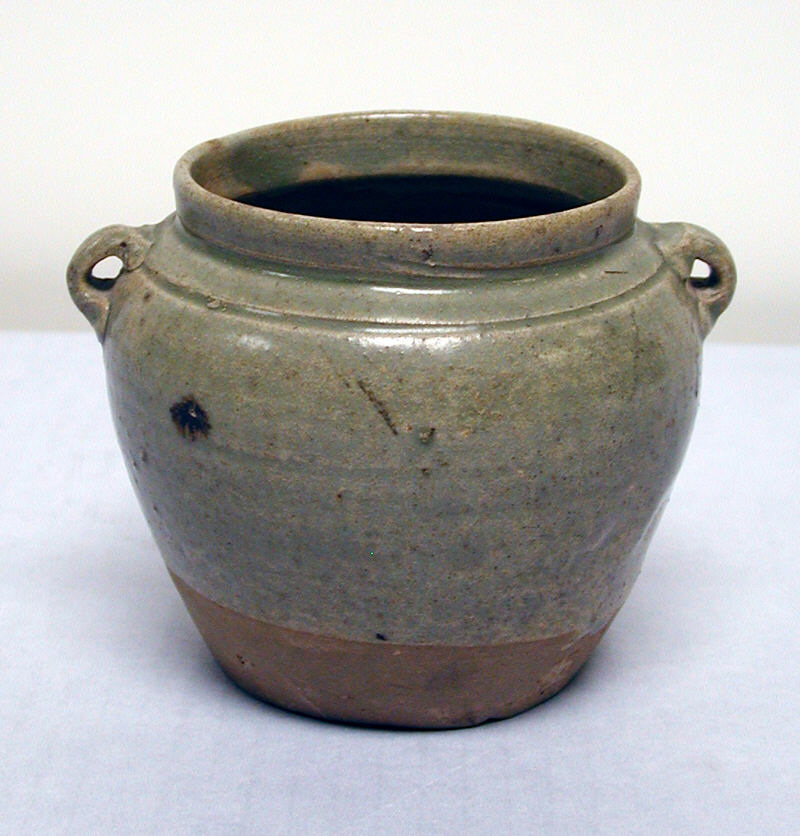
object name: jar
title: Jar (Guan)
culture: chinese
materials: stoneware